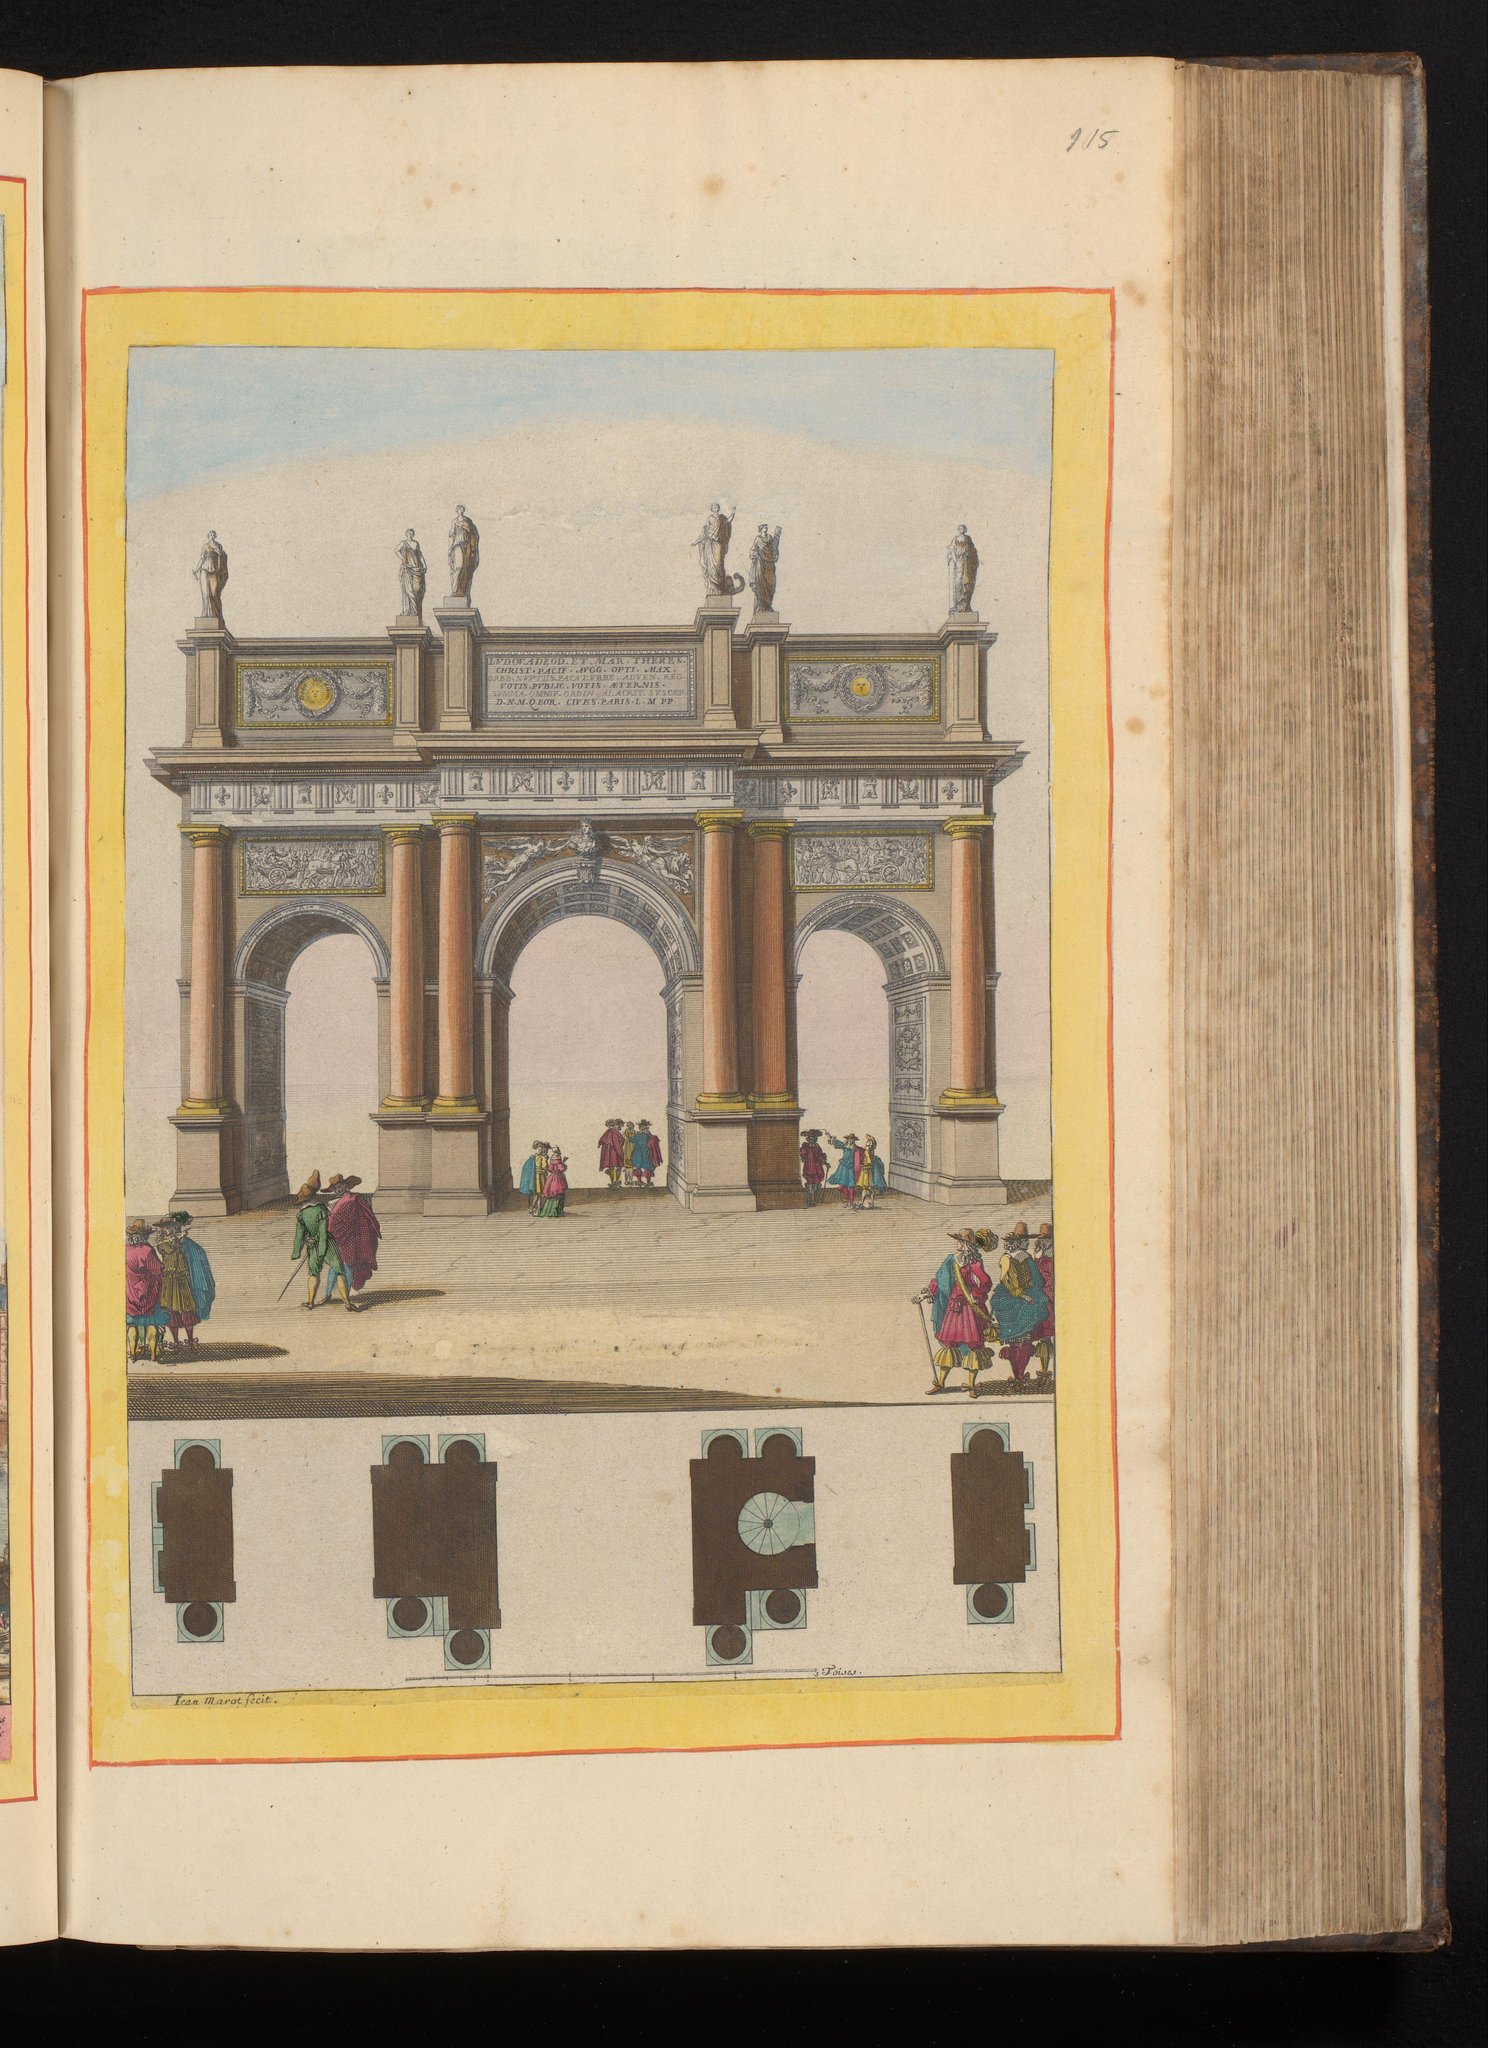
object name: album leaf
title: Eerste triomfboog in de Faubourg Saint Antoine tijdens de Blijde Intocht van koning Lodewijk XIV van Frankrijk en zijn vrouw Maria Theresia in Parijs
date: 1660-1662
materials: paper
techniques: etching, hand coloring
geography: paris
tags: triumphal arch, triumphal entry and public reception, pageant, 'entrée solennelle', 'joyeuse entrée'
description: Prent uit: L'entrée triomphante de Leurs Majestez Louis XIV, roy de France et de Navarre et Marie-Thérèse d'Austriche, son espouse, dans la ville de Paris ... au retour de la signature de la paix généralle et de leur heureux mariage. Parijs: Pierre le Petit, 1662.